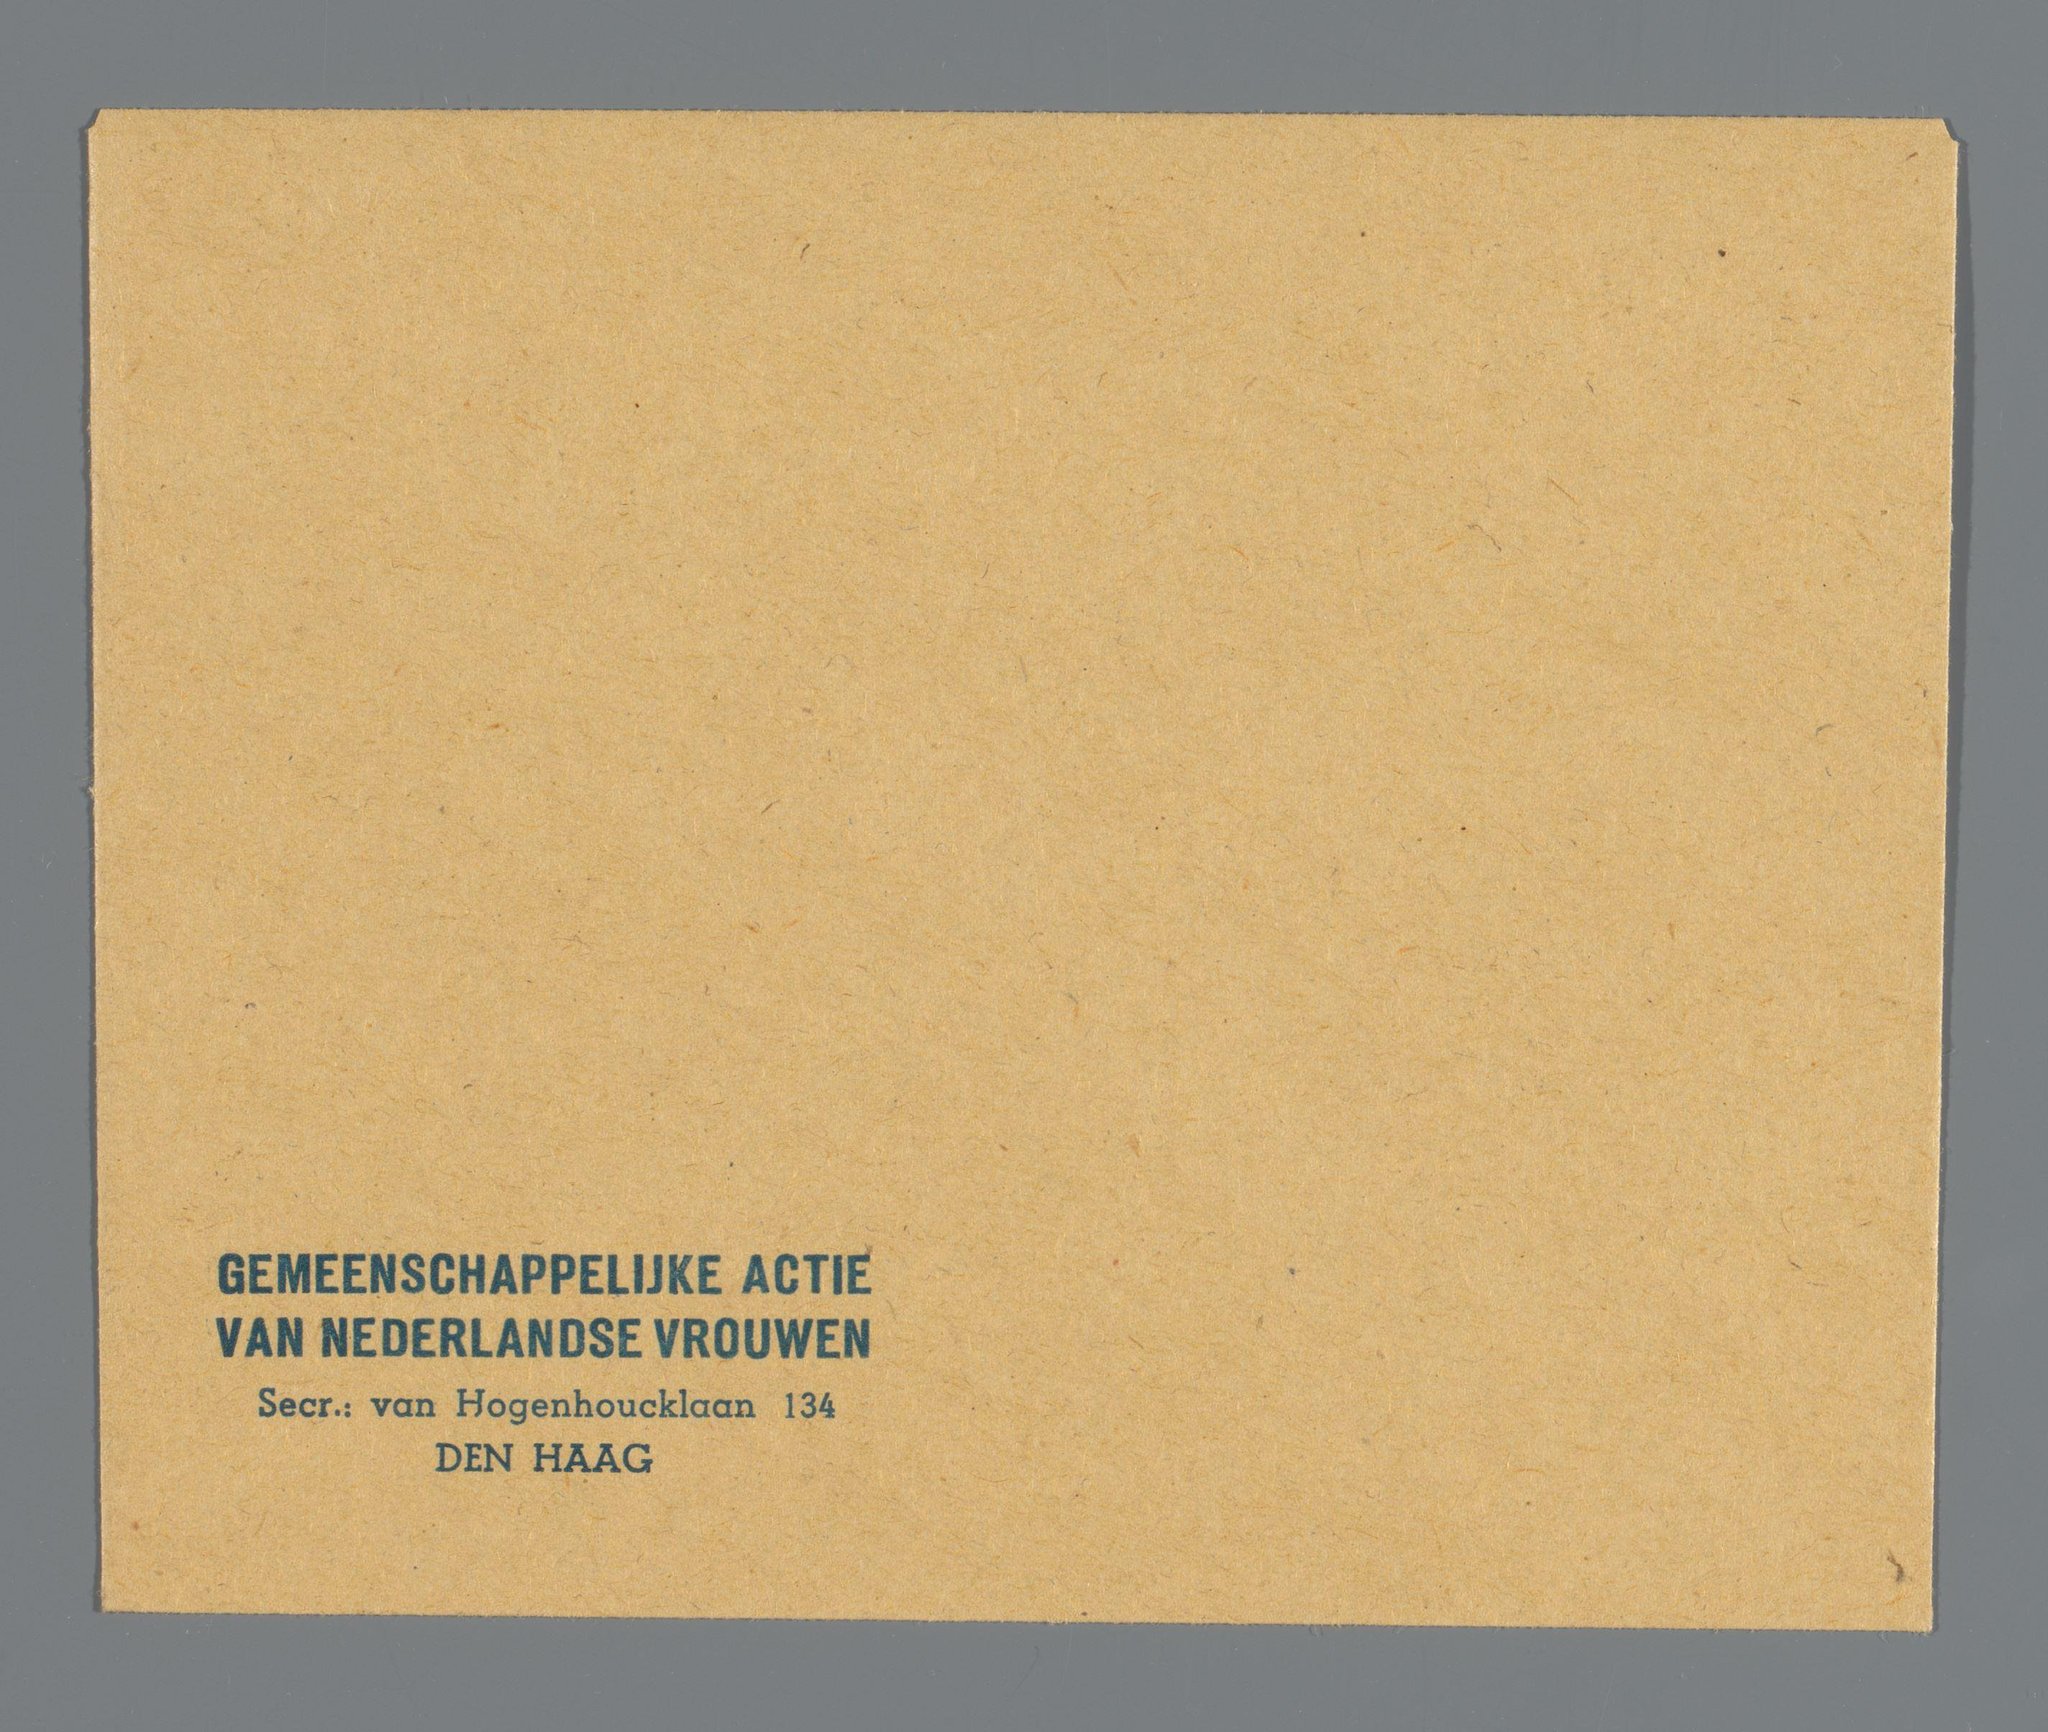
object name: pamphlet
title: Pamflet De Gemeenschapelijke Actie van Nederlandse Vrouwen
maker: wilhelmina van t rood-gerth van wijk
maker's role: activist, feminist, schrijver, secretaresse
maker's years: 1900-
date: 1948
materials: paper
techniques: printing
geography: the hague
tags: dutch east indies, the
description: Nederlandse gevangenen in Djokja. Politionele akties in Nederlands-Indië. Deze aktie was bedoeld om de Nedelrandse overheid en het Nederlandse volk bekend te maken met het feit dat er nog 15.000 Nederlanders gevangen werden gehouden in kampen en een aantal Nederlandse vrouwen en meisjes in gedwongen concubinaat met soldaten van de republiek leefden. De Actie nam de Nederlandse regering kwalijk dat er niets aan werd gedaan.